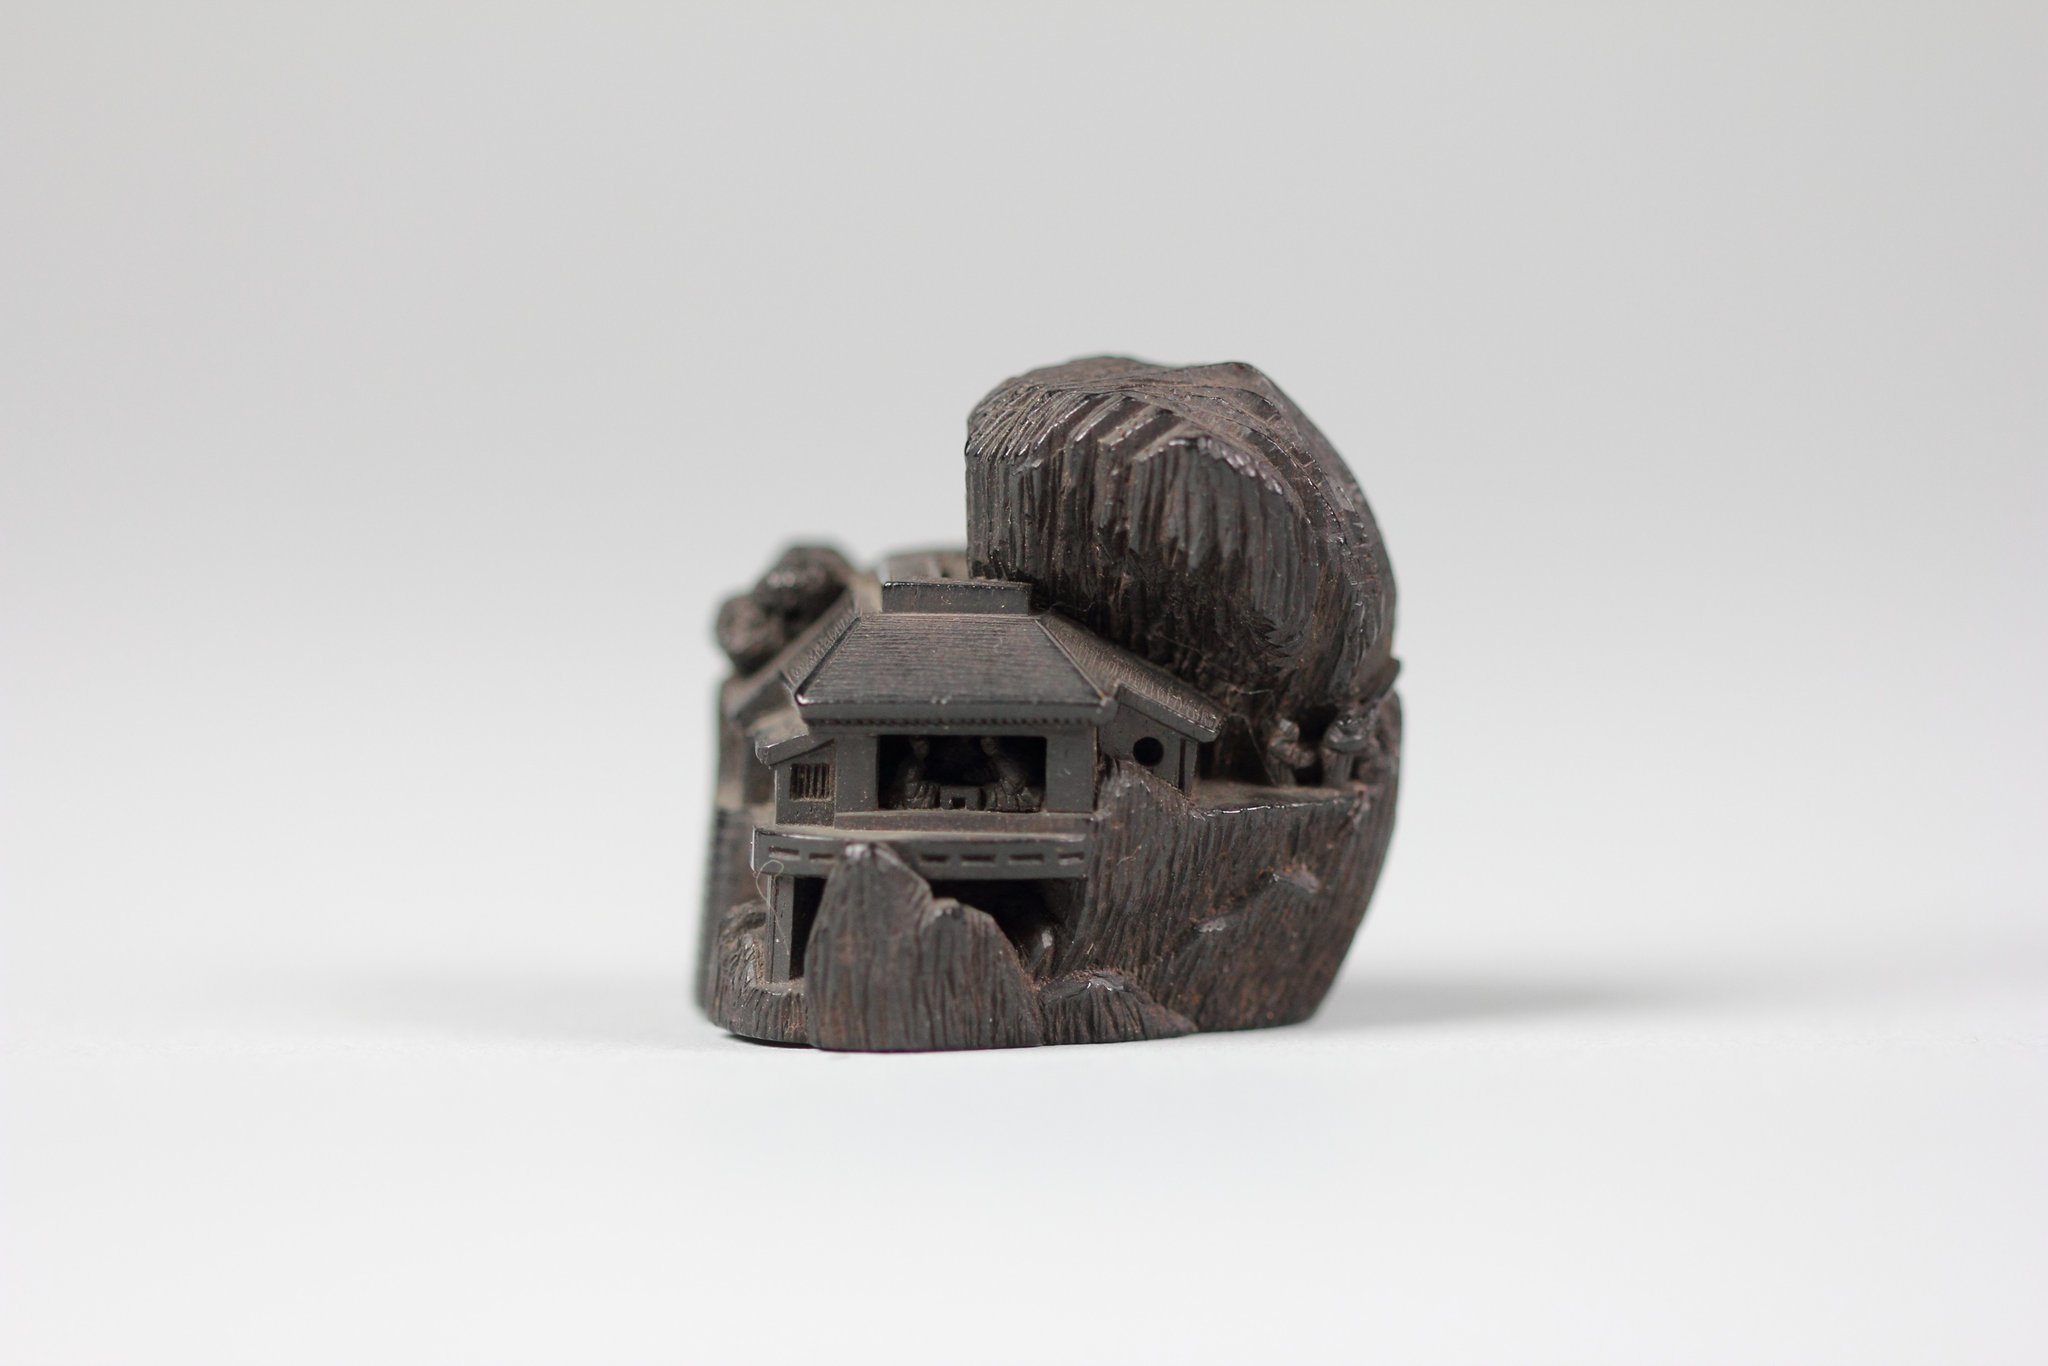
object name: netsuke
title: Rocky Landscape with House and Trees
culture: japanese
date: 1801-1900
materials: wood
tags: houses